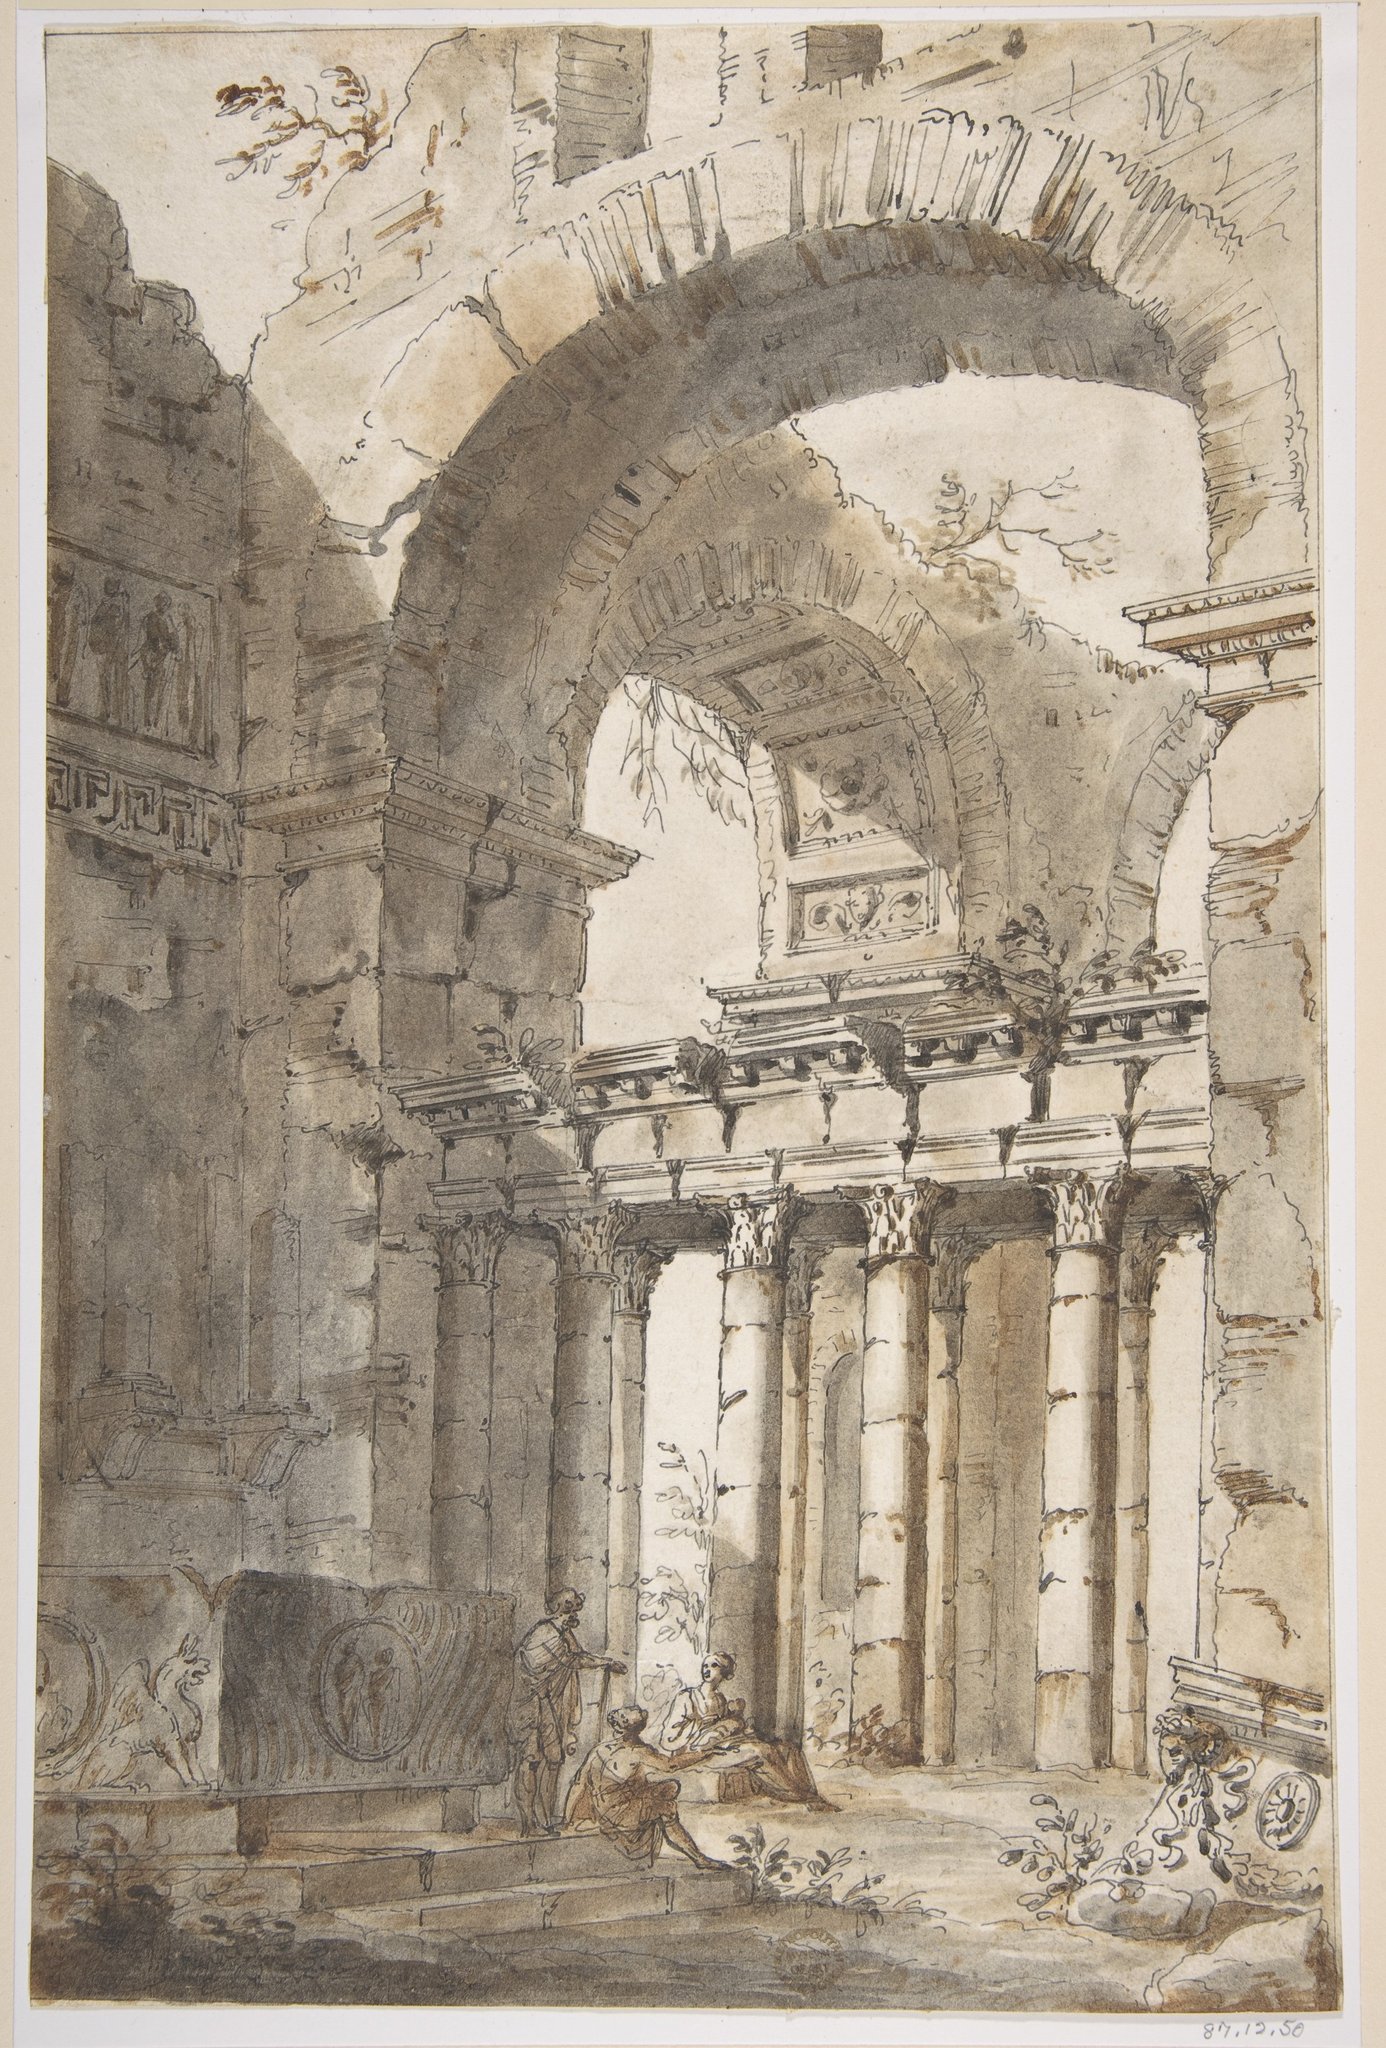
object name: drawing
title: Ruins of a Basilica or Mausoleum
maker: giovanni paolo panini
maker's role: artist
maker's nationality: italian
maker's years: 1691-1765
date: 1691-1765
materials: ink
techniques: brush, pen, wash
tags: arches,ruins